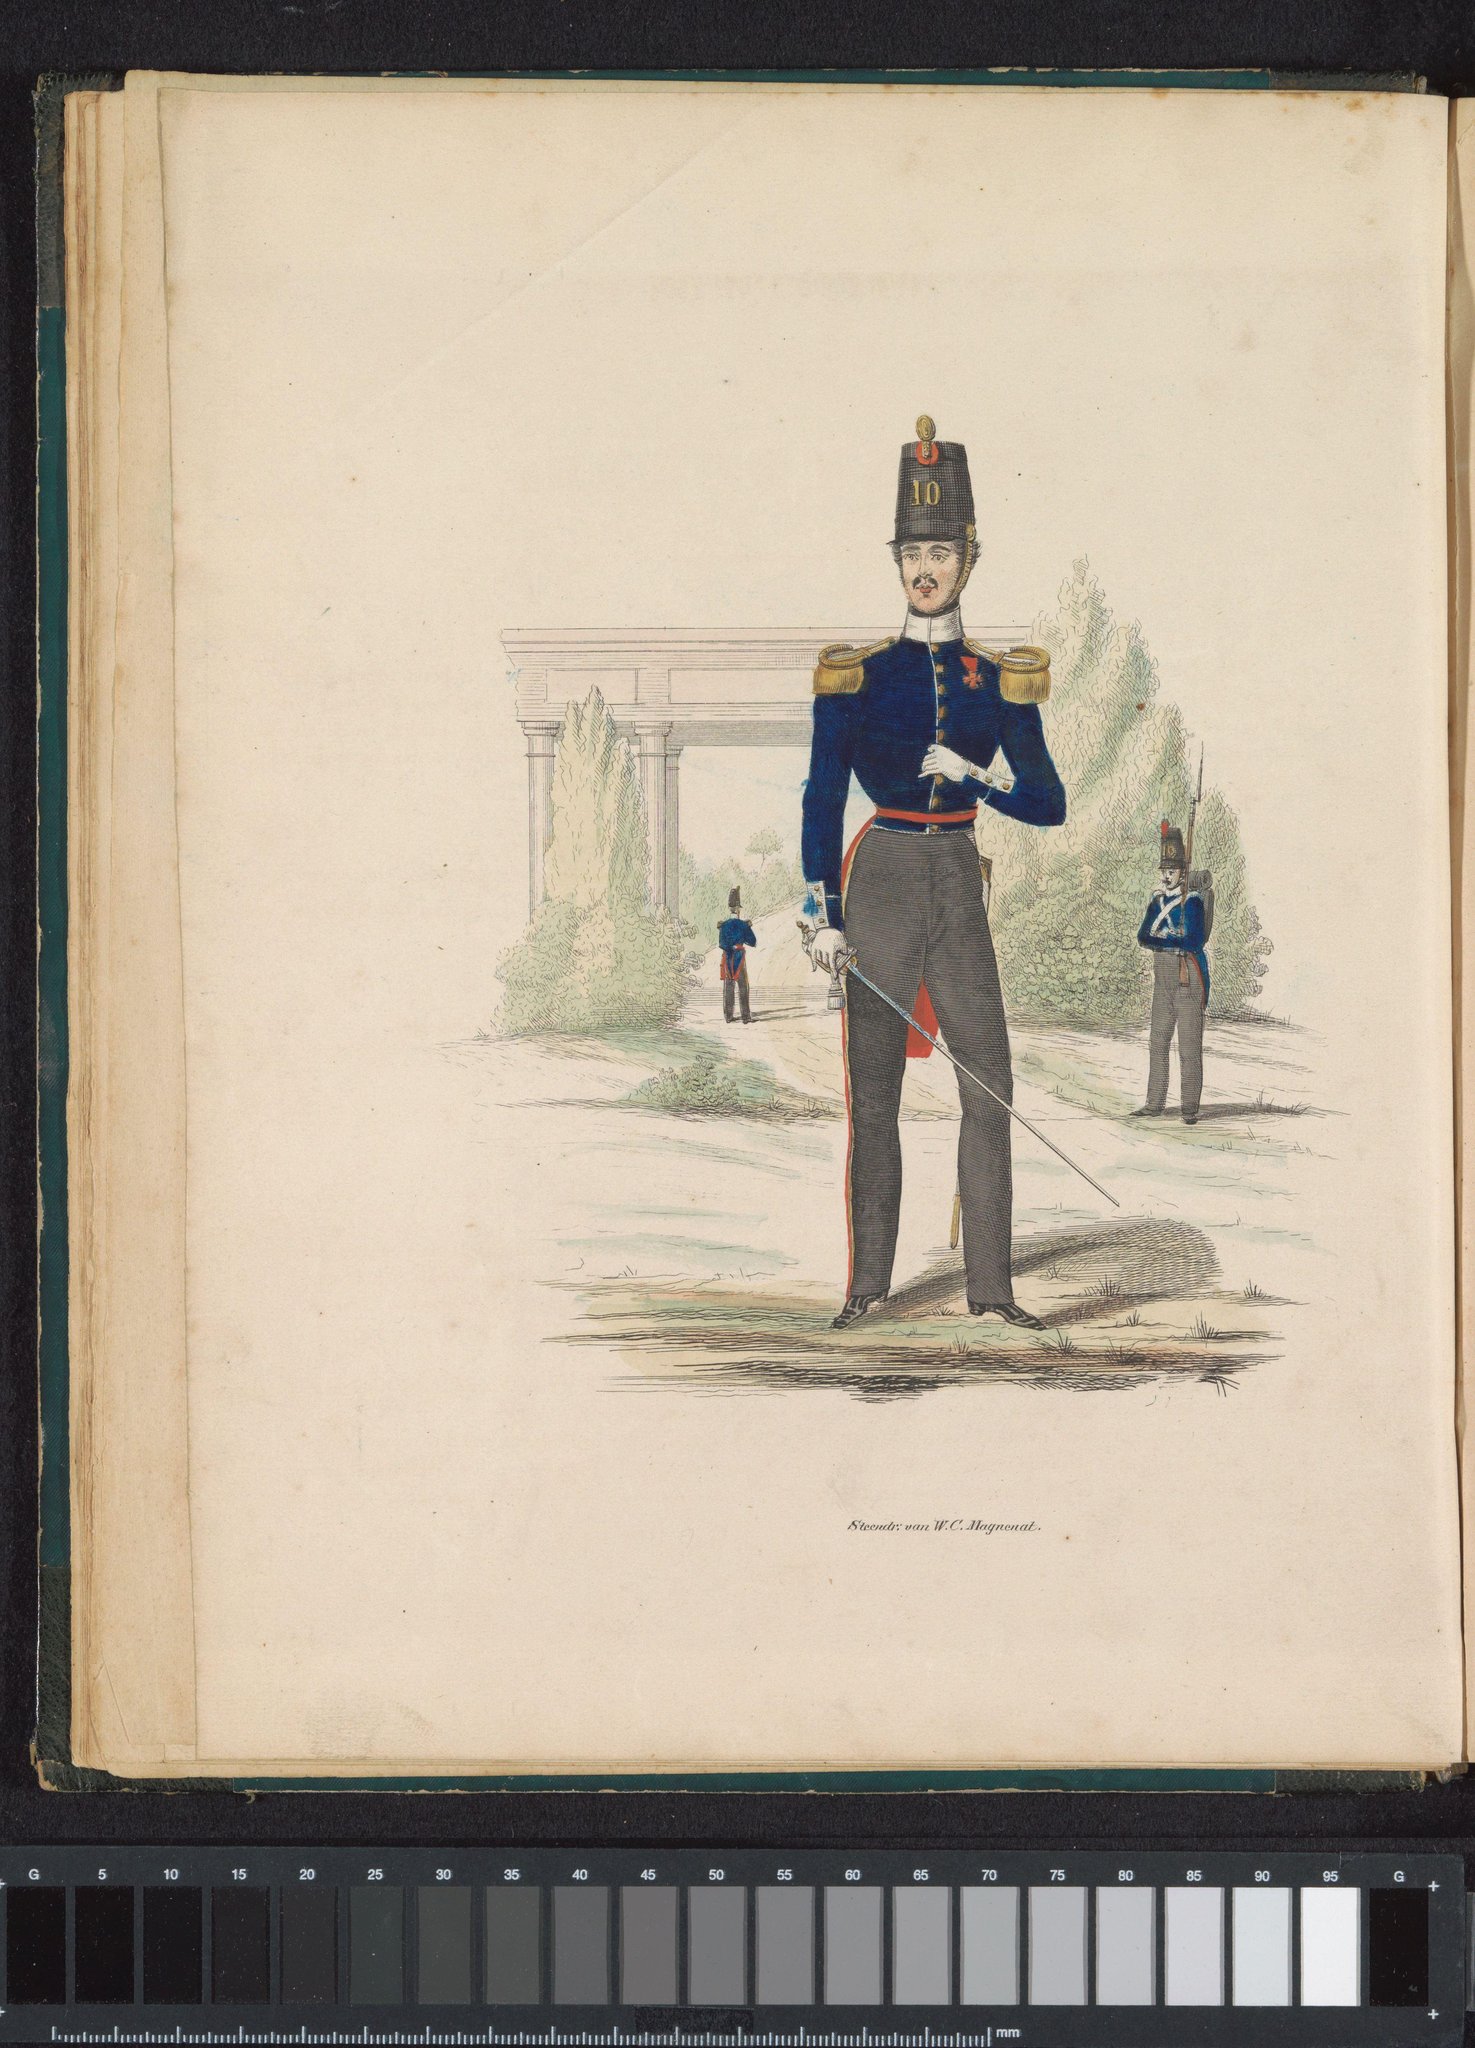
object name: print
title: Uniform van de officieren van de infanterie, 1845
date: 1845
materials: paper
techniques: hand coloring, lithograph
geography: amsterdam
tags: (military) uniforms, netherlands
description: Uniform van de officieren van de infanterie. Illustratie in een boek uit 1845 over de uniformen en kledingstukken van de Nederlandse land-, zeemacht en schutterijen in Nederland en in de overzeese gebiedsdelen.